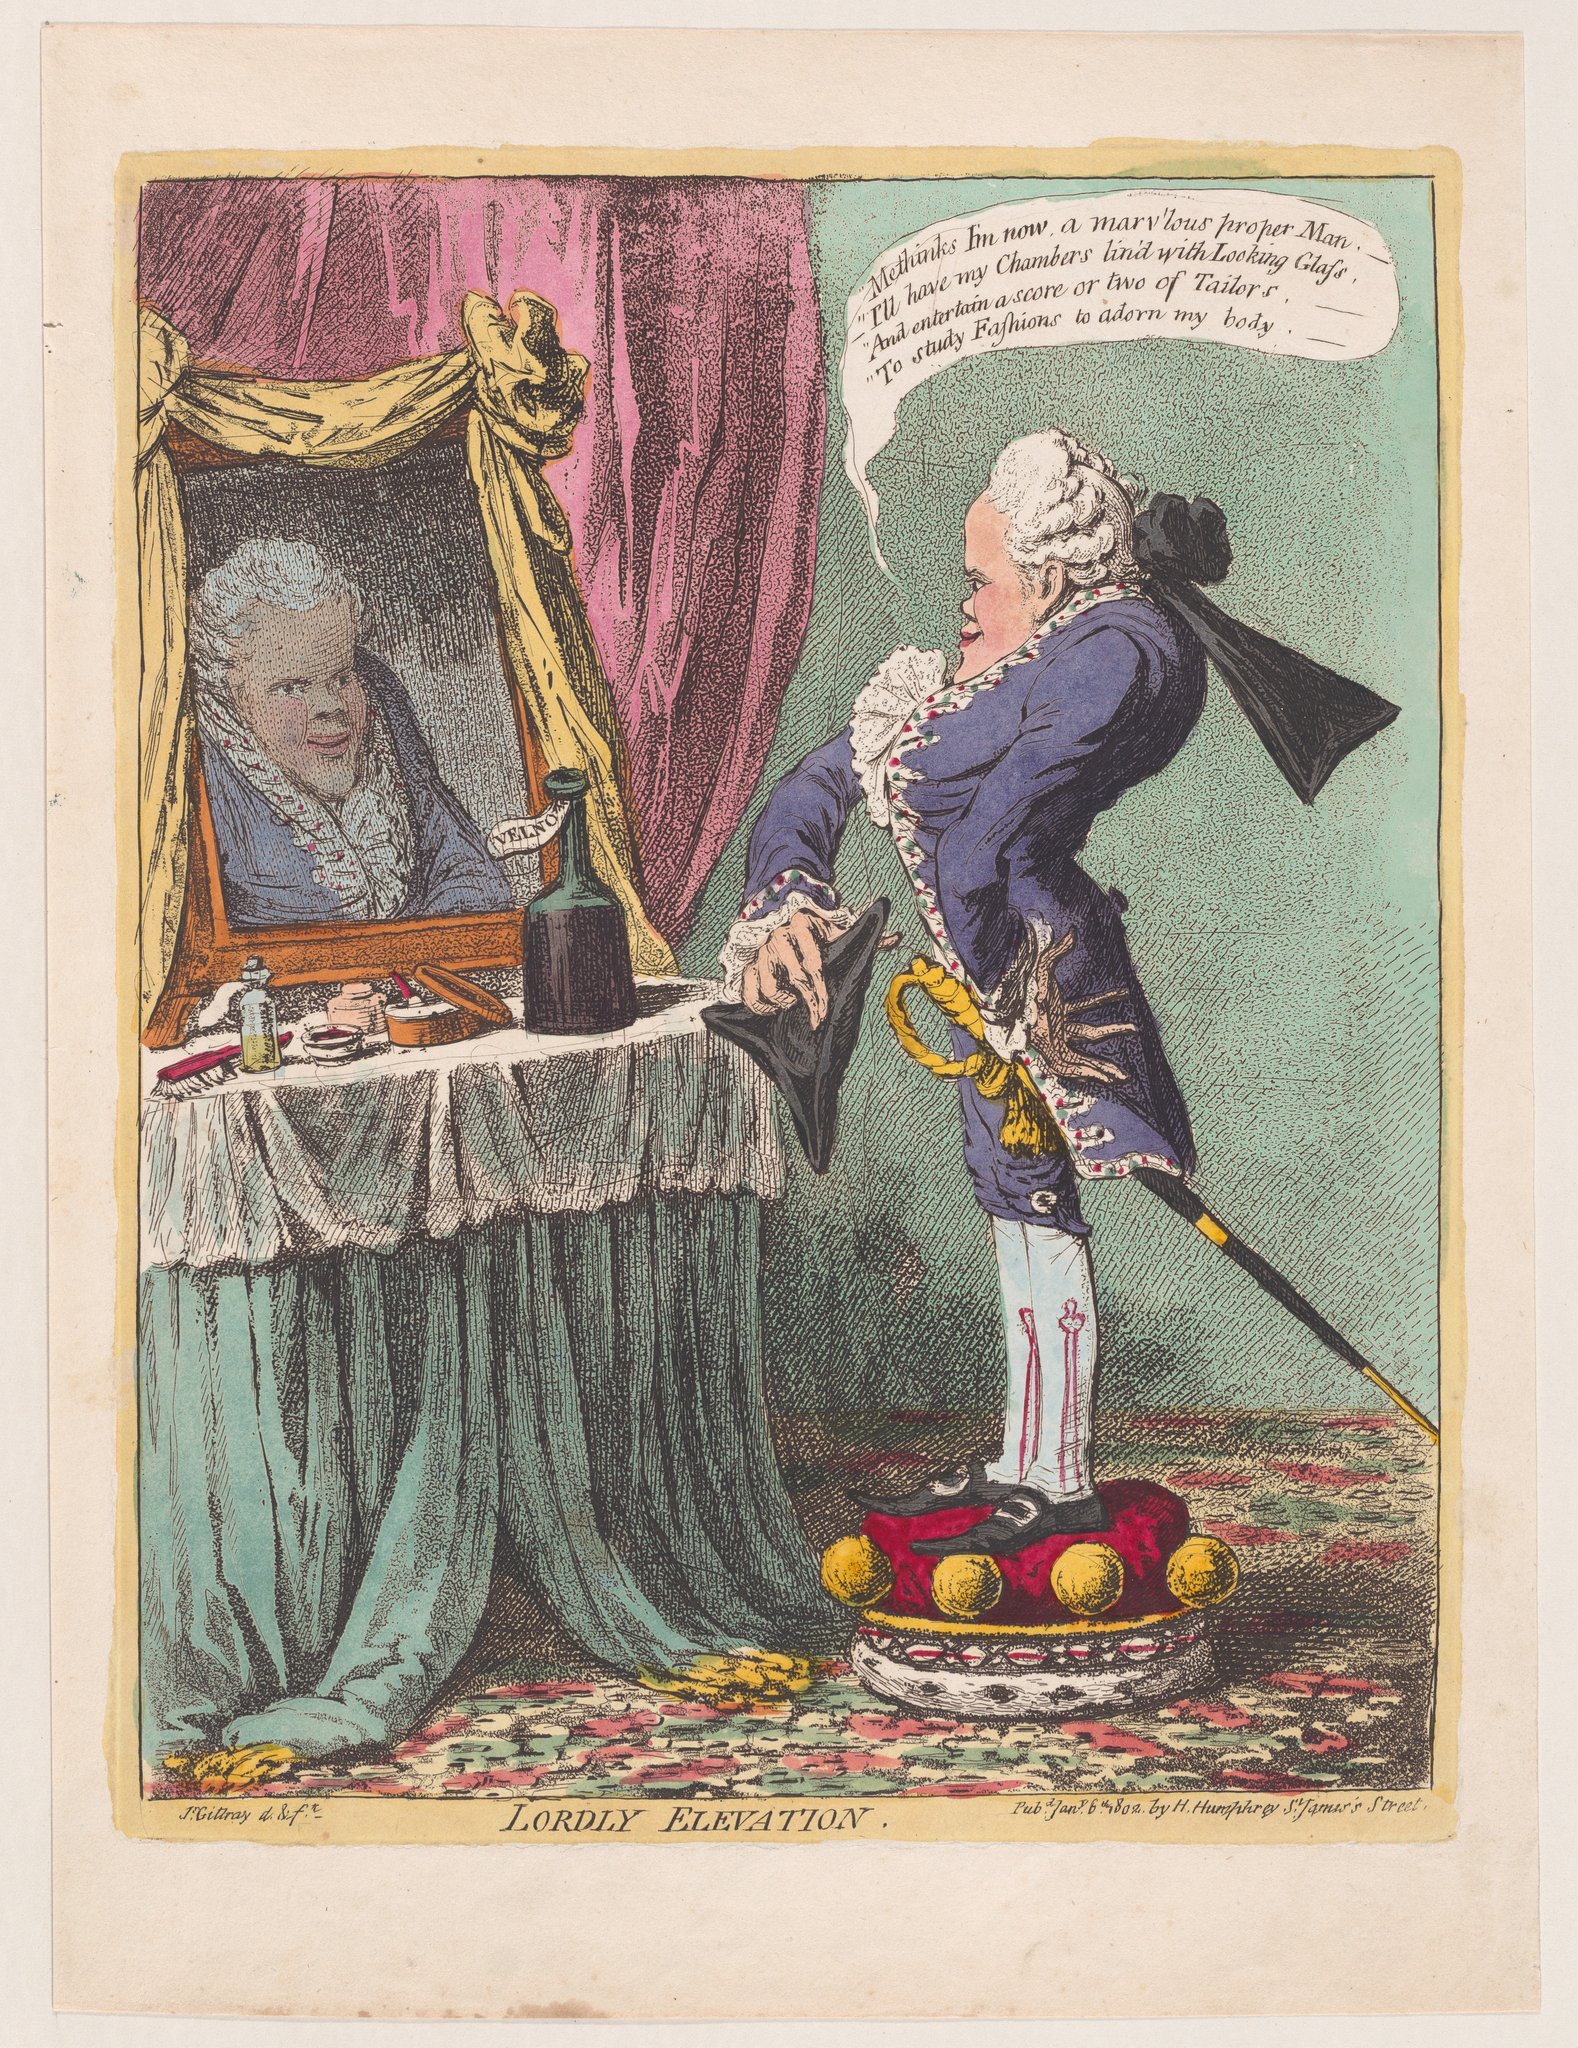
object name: print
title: Lordly Elevation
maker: james gillray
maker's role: artist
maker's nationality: british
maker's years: 1756-1815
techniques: etching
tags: satire,men,mirrors,caricature